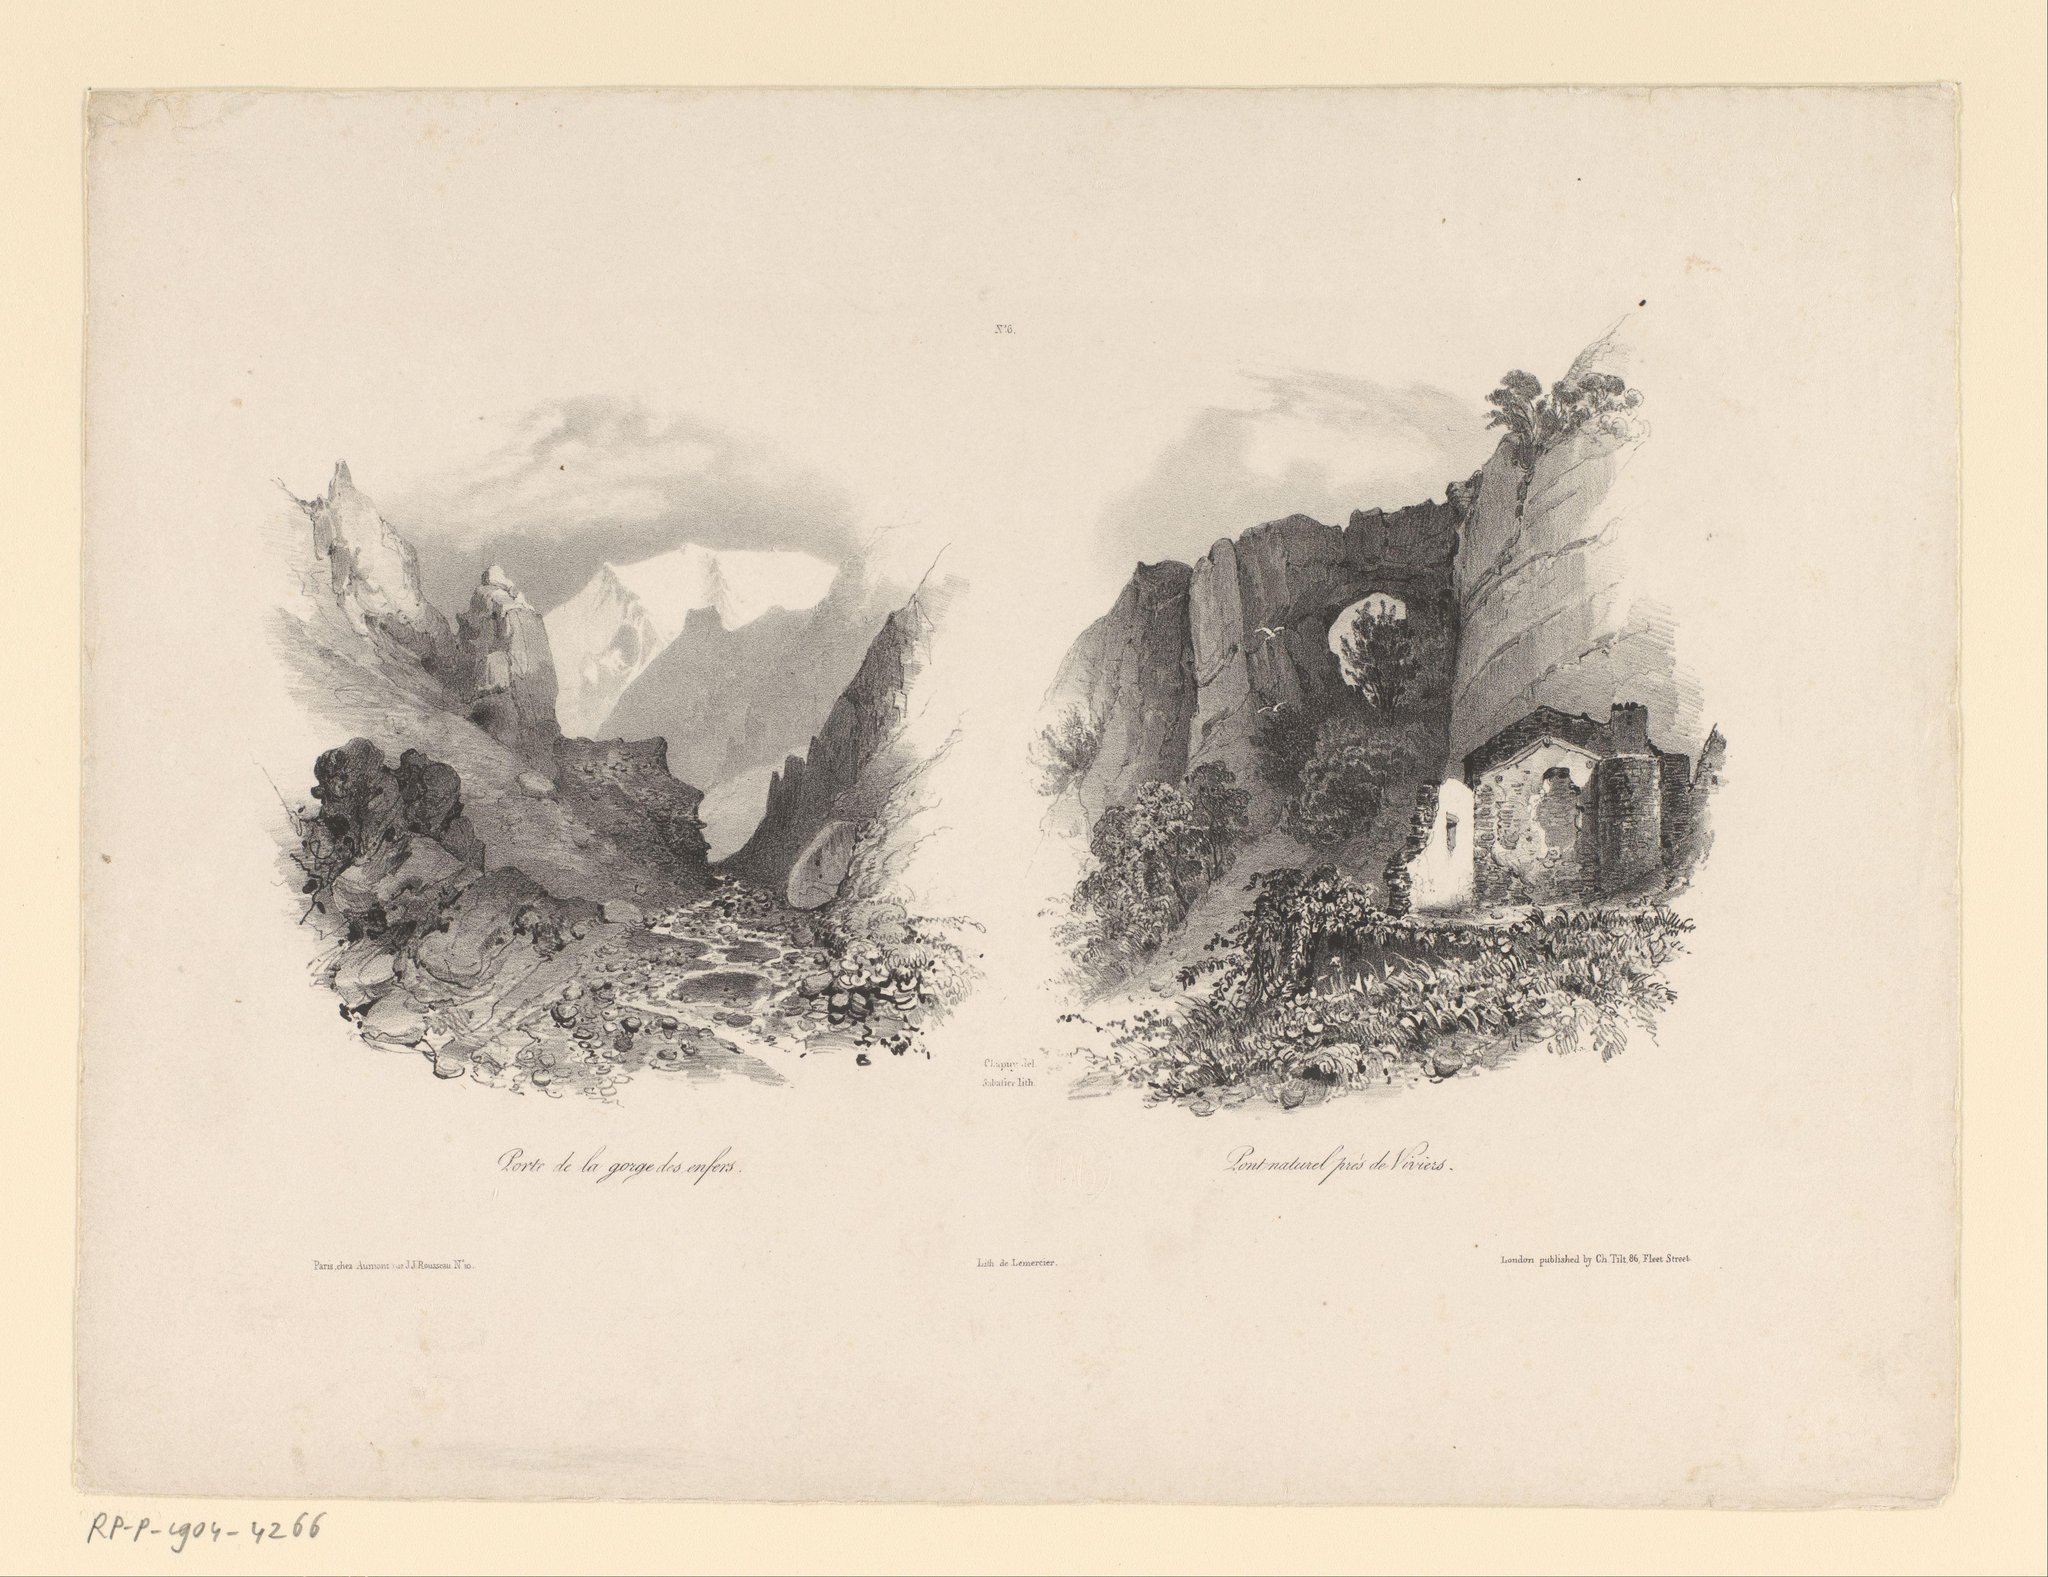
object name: print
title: Gezicht op besneeuwde bergtoppen en gezicht op een natuurlijke brug bij Viviers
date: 1828-1839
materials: paper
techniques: lithograph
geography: paris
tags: mountains - hh - ideal landscapes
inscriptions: collector's mark: Lugt 2228, check stamp: Lugt 88b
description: Twee voorstellingen op één blad. Boven genummerd: No. 6.